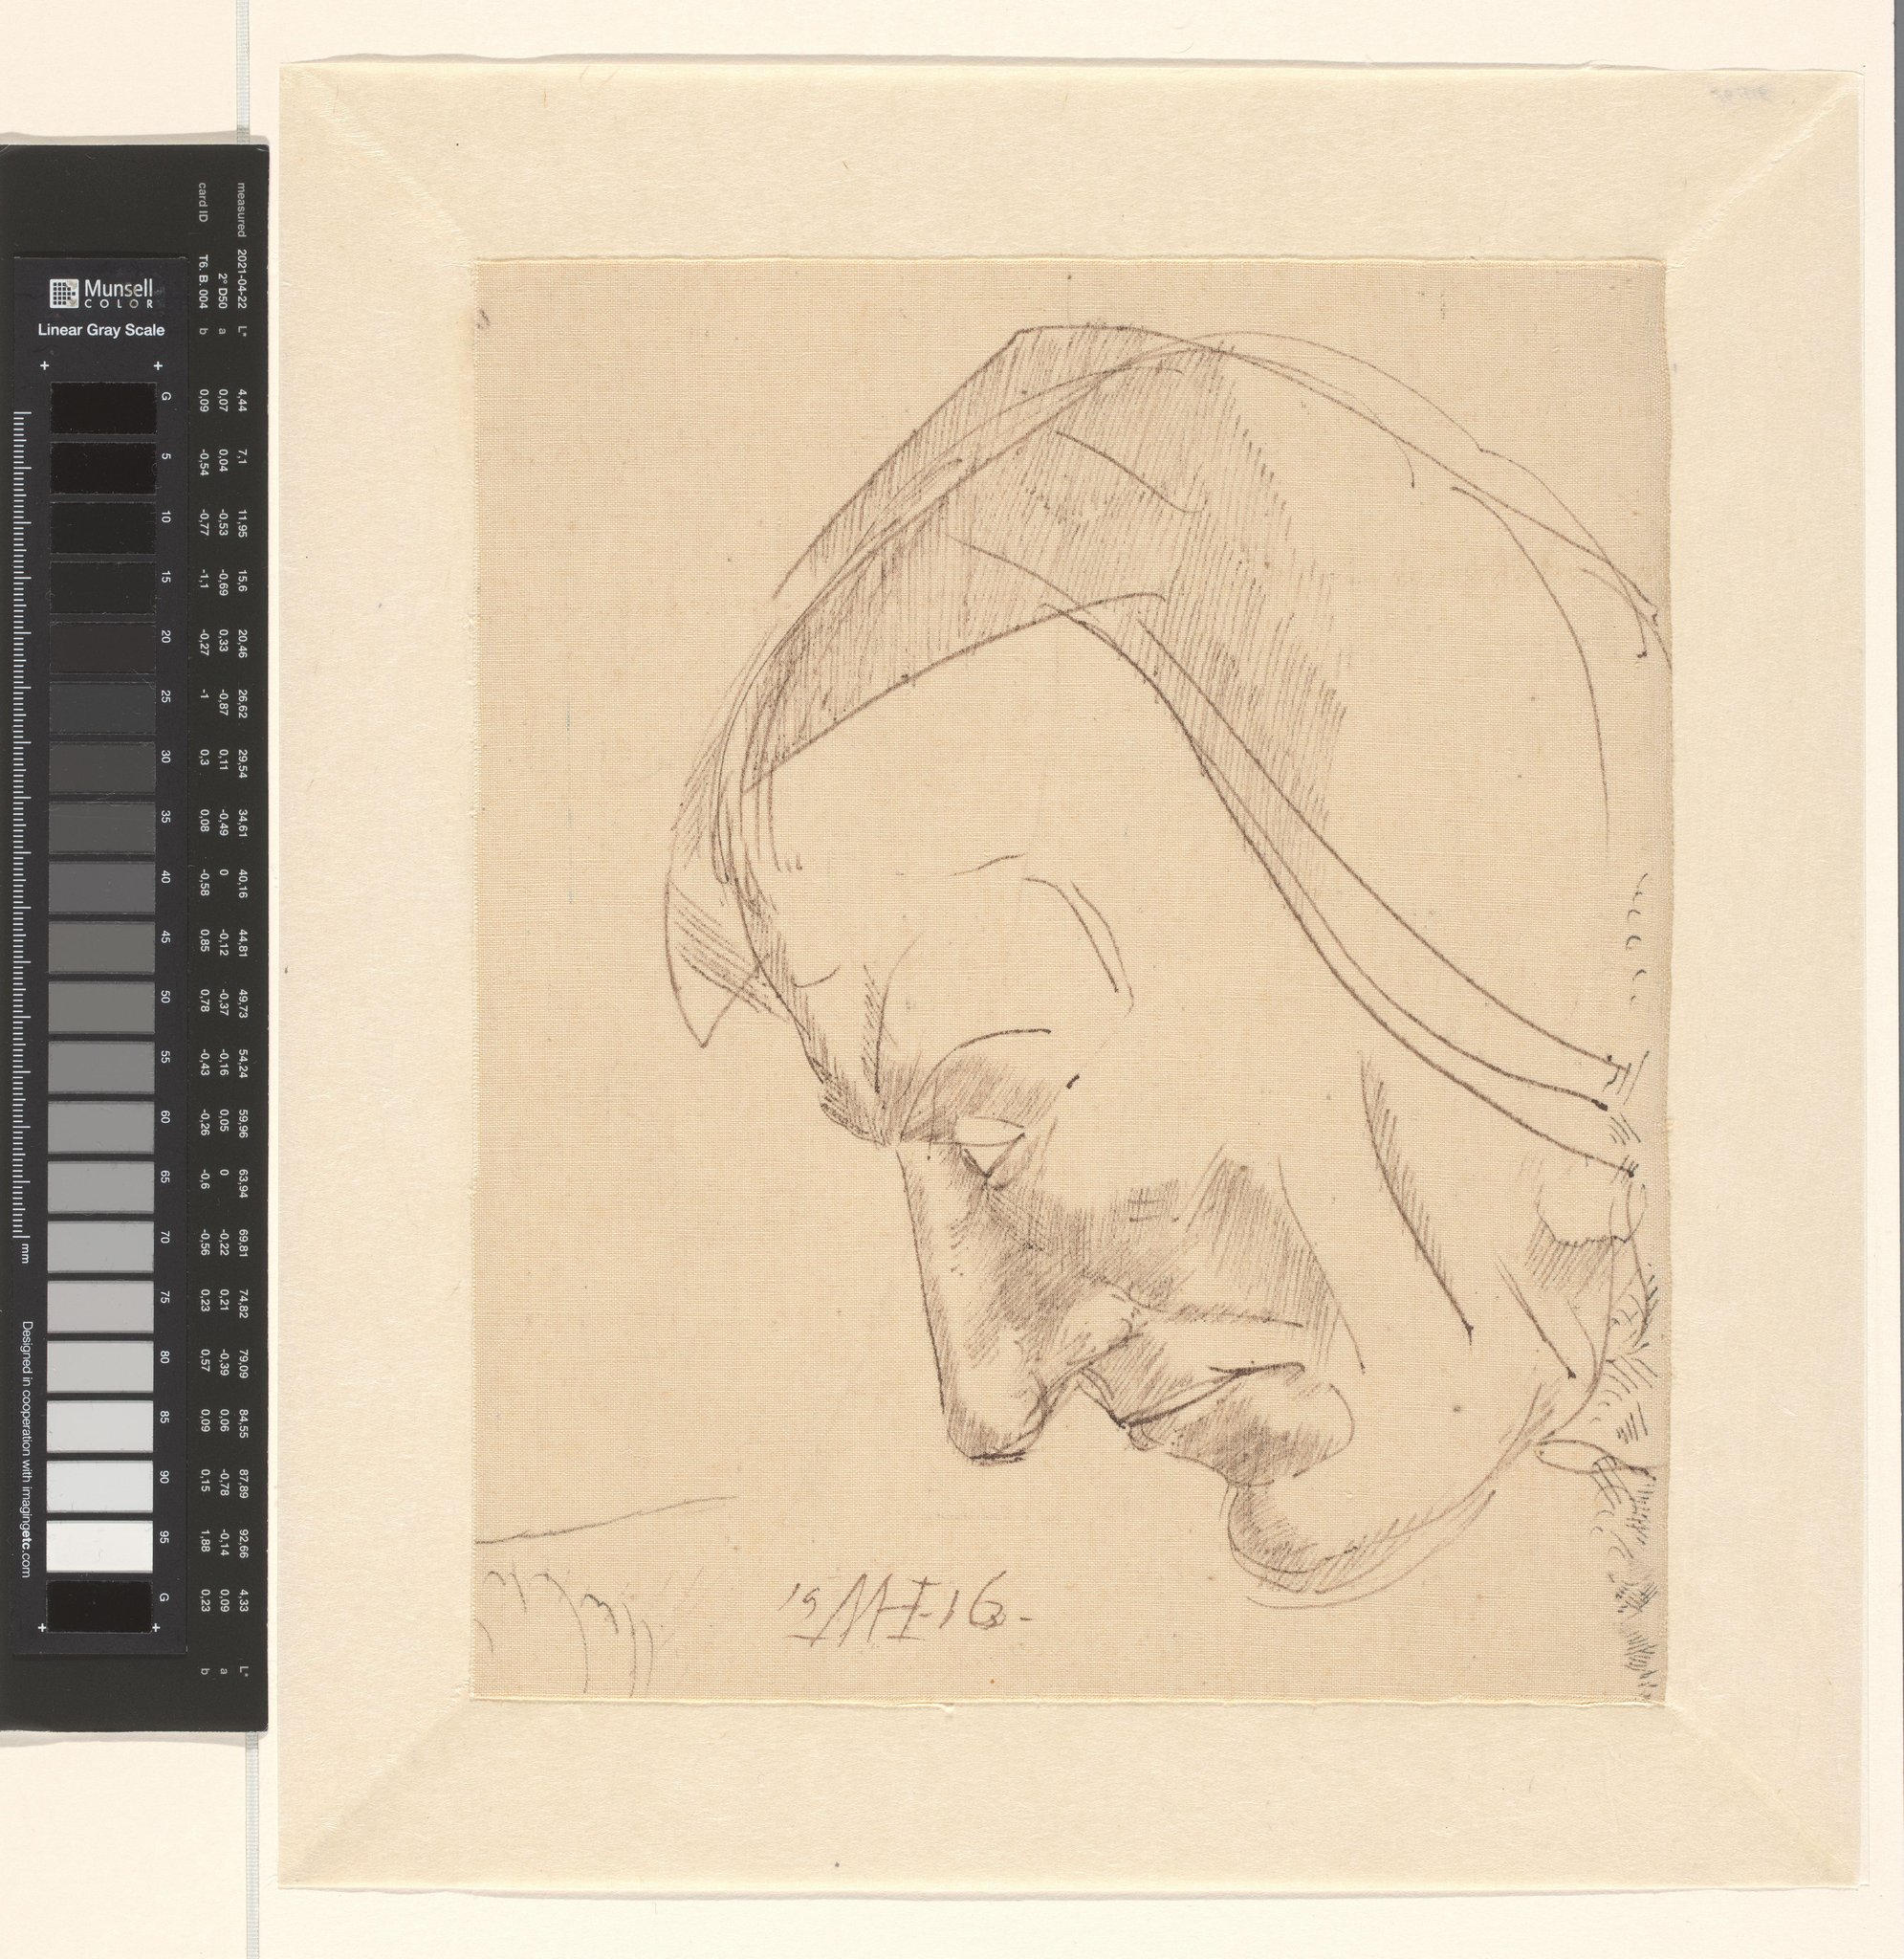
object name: drawing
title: Kop van een man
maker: marius holleman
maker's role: draughtsman, print maker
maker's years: 1878-1926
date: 1916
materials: ink, linen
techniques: pen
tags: head (human)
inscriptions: date